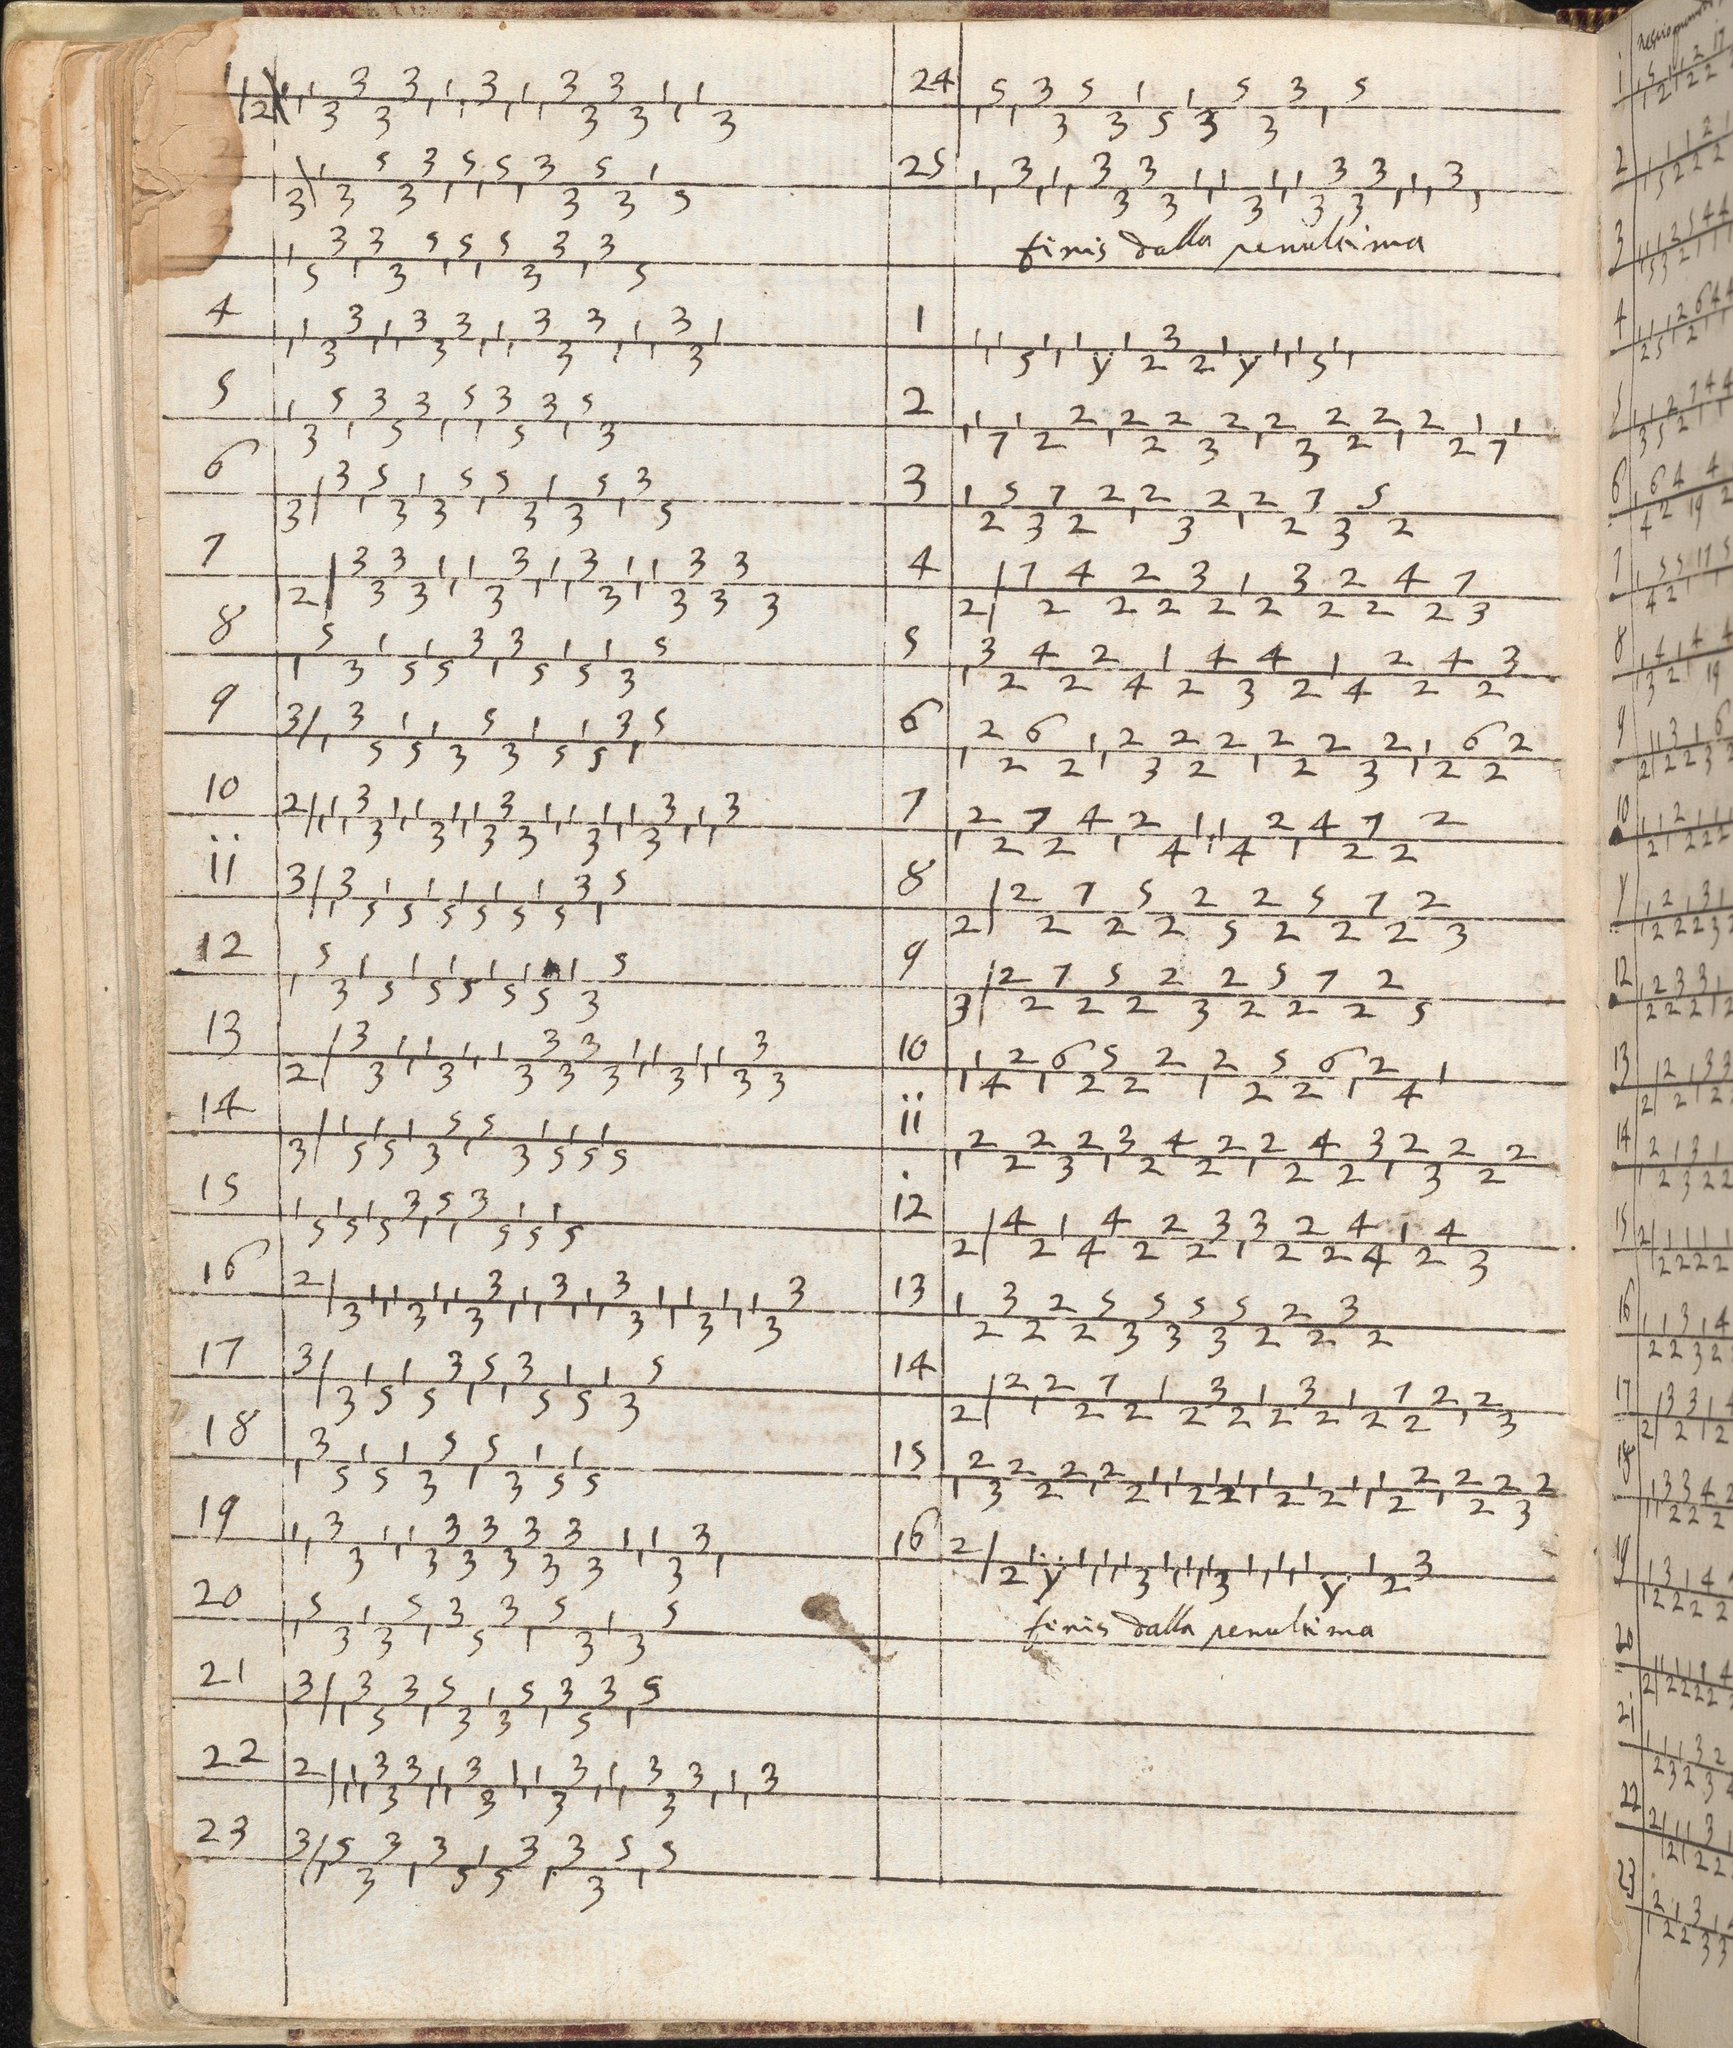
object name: book print ornament architecture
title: Ein new getruckt model Büchli...Page 26, recto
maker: johann schönsperger the younger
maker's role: publisher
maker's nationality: german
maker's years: 1490-1550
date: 1529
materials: ink, paper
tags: mathematics